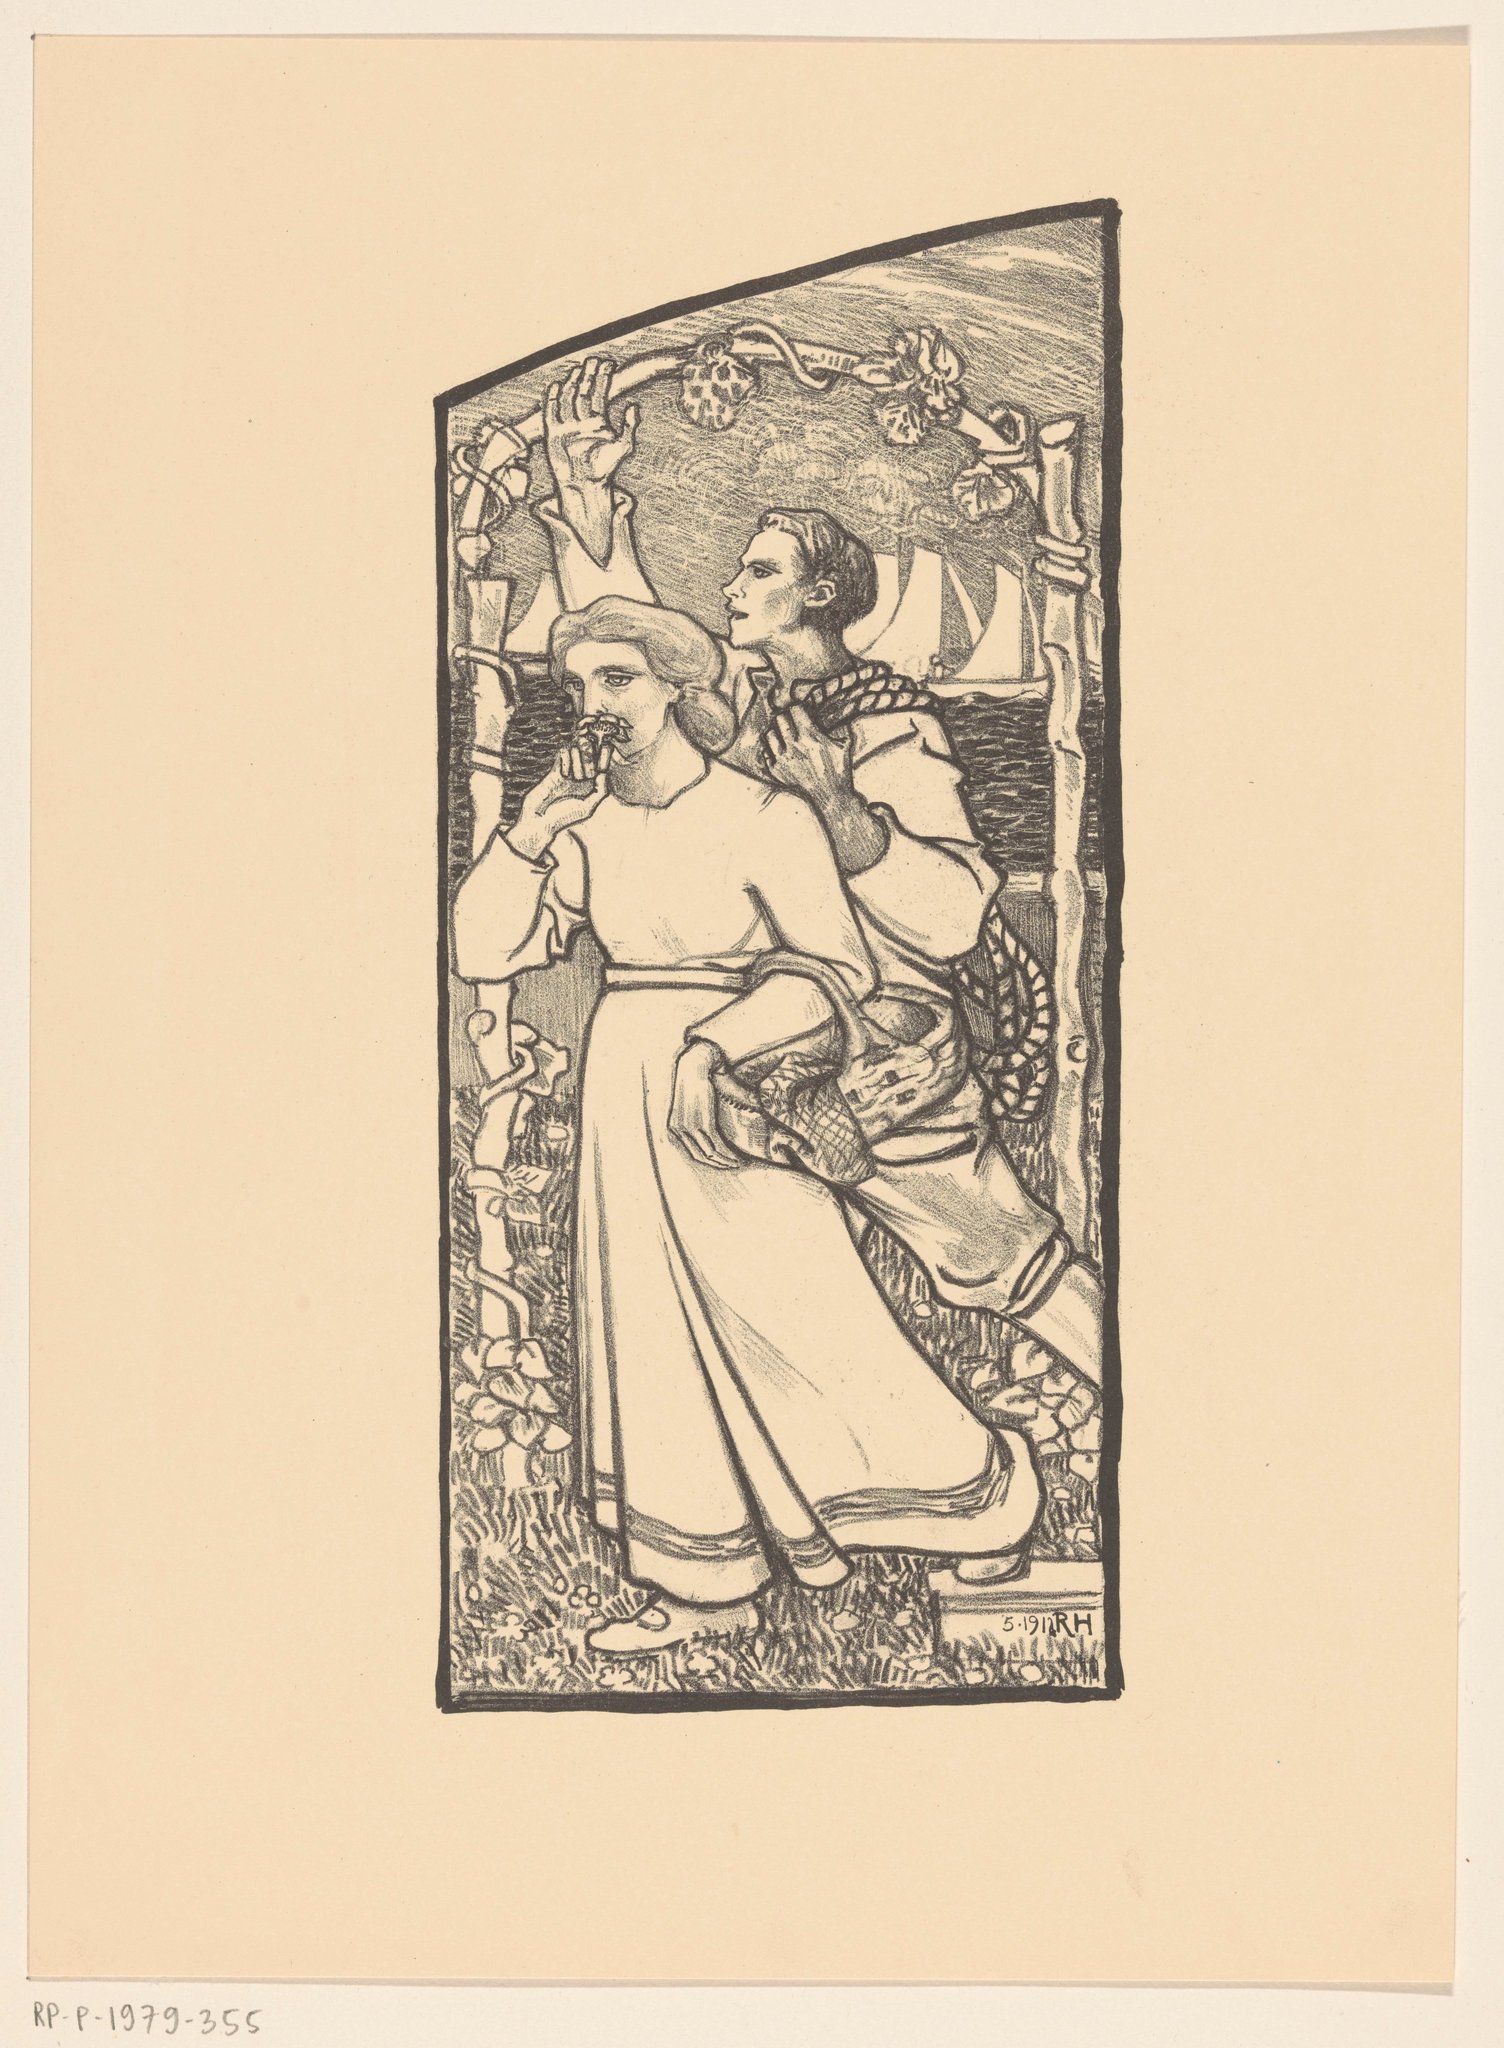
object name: print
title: Meisje met een mand en jongen met een touw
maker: richard nicolaüs roland holst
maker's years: 1868-1938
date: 1905-1912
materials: paper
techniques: lithograph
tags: sailing-ship, sailing-boat, garden, container made of plant material other than wood: basket, tools, aids, implements ~ crafts and industries: rope, child (at home)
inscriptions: collector's mark: Lugt 2228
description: Het meisje en de jongen bevinden zich bij een boog waar een klimplant omheen groeit. Op de achtergrond zeilschepen op het water.